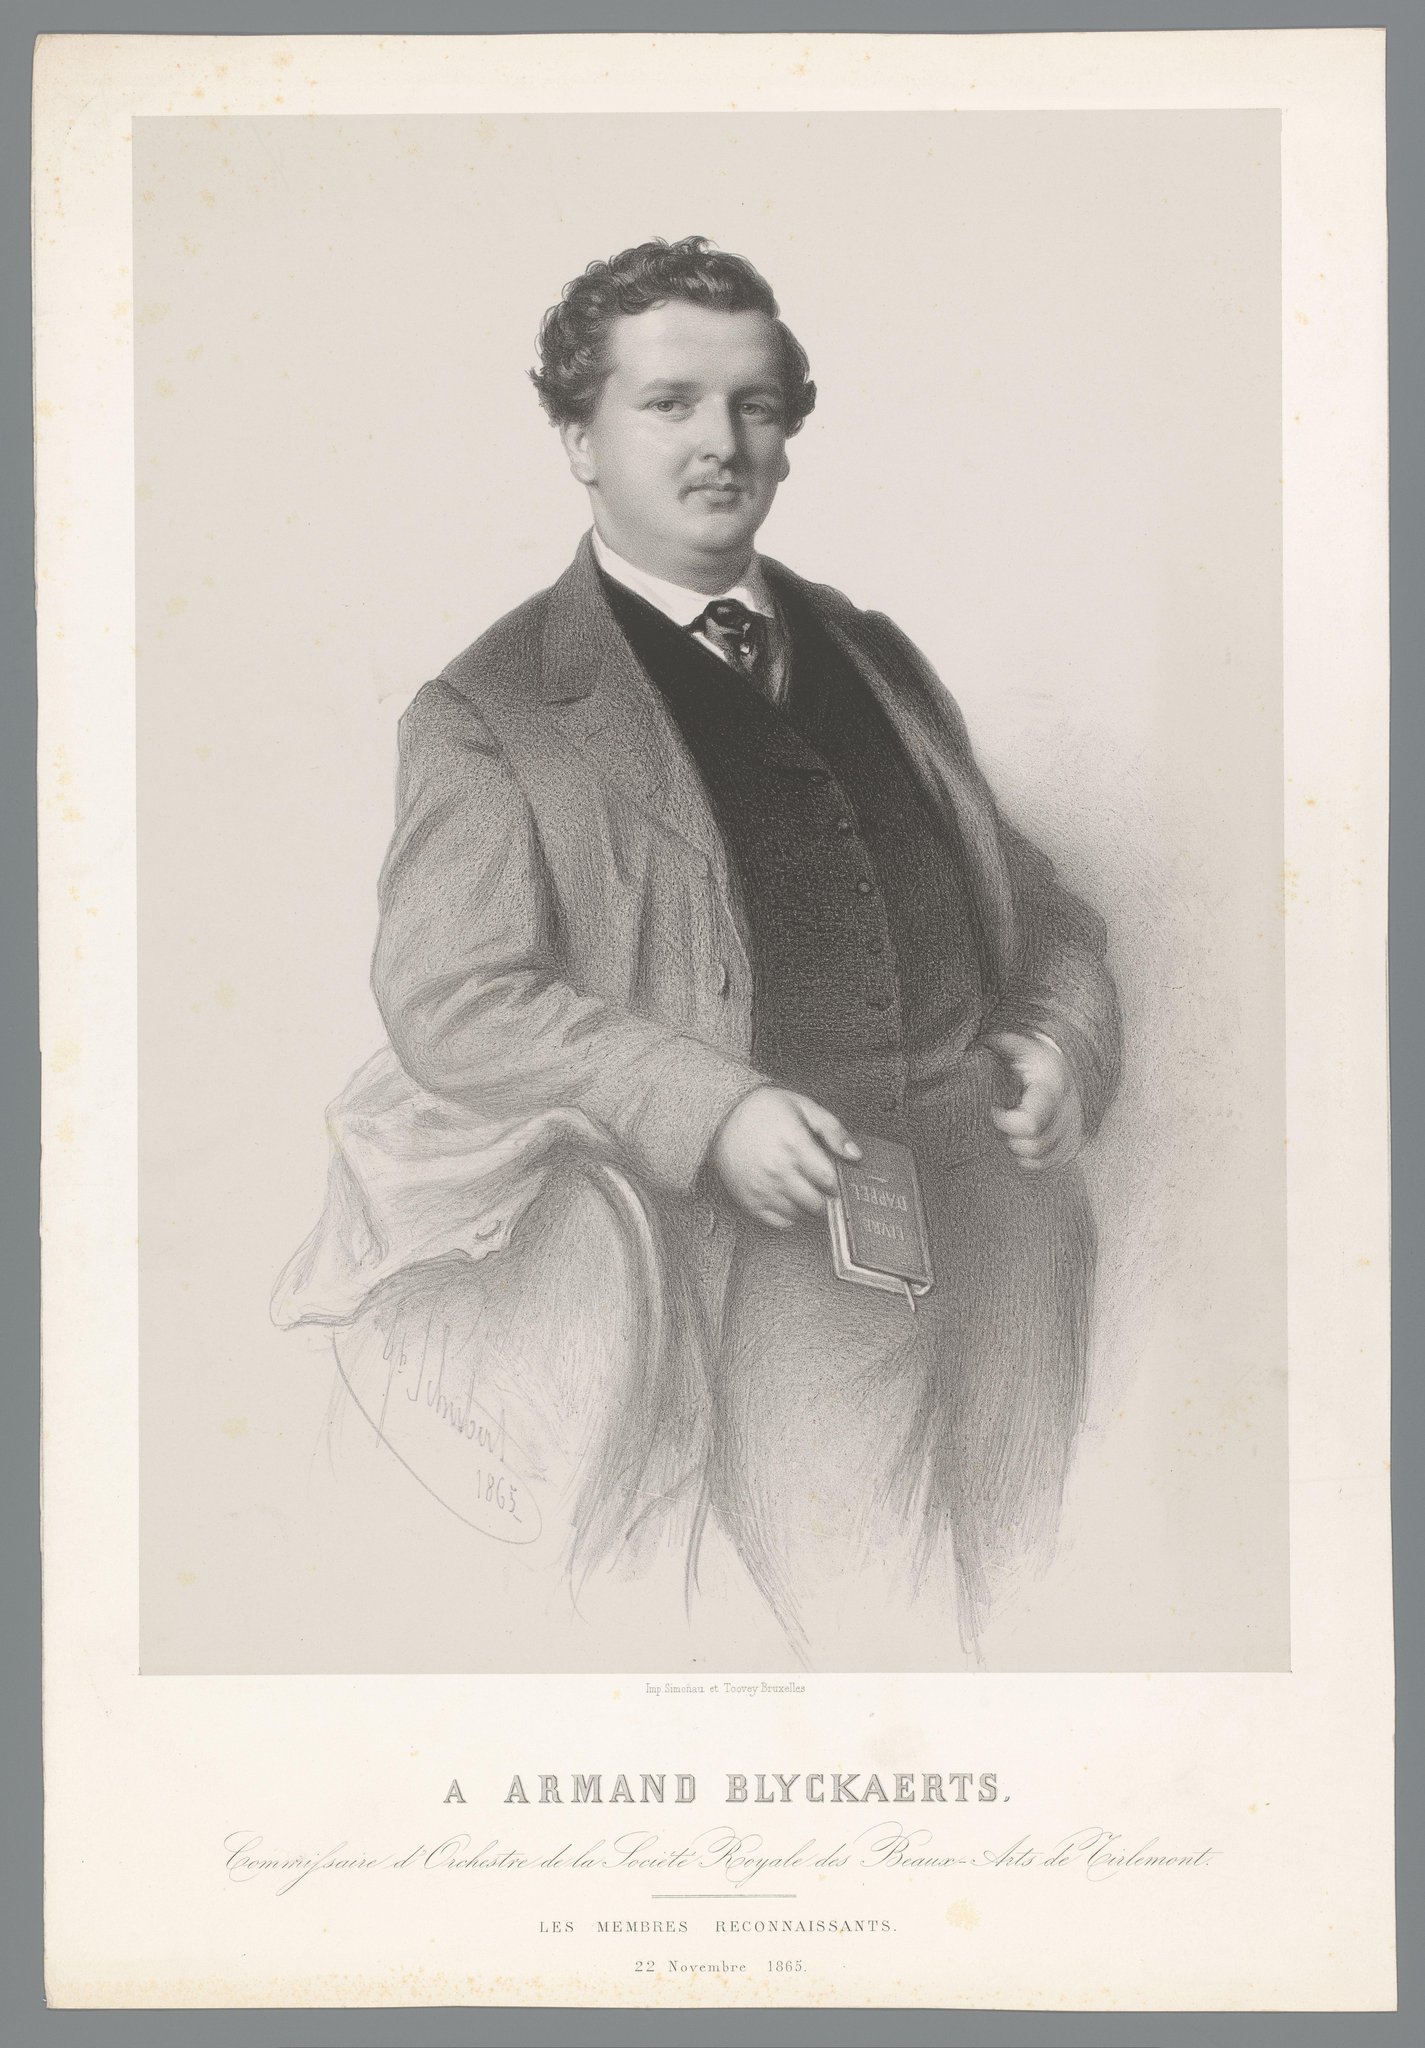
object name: print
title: A Armand Blyckaerts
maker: joseph schubert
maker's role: print maker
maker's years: 1816-1885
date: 1865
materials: paper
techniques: lithograph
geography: brussels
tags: historical persons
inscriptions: collector's mark: Lugt 2228